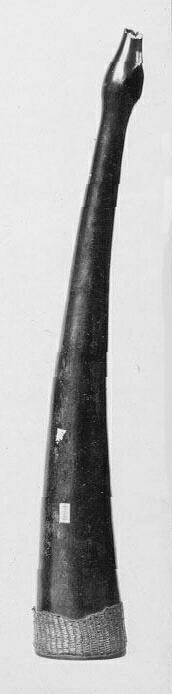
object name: horn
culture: mongo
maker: bakutu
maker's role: maker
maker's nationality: west coast africa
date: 1867-1900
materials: ivory, skin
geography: democratic republic of the congo